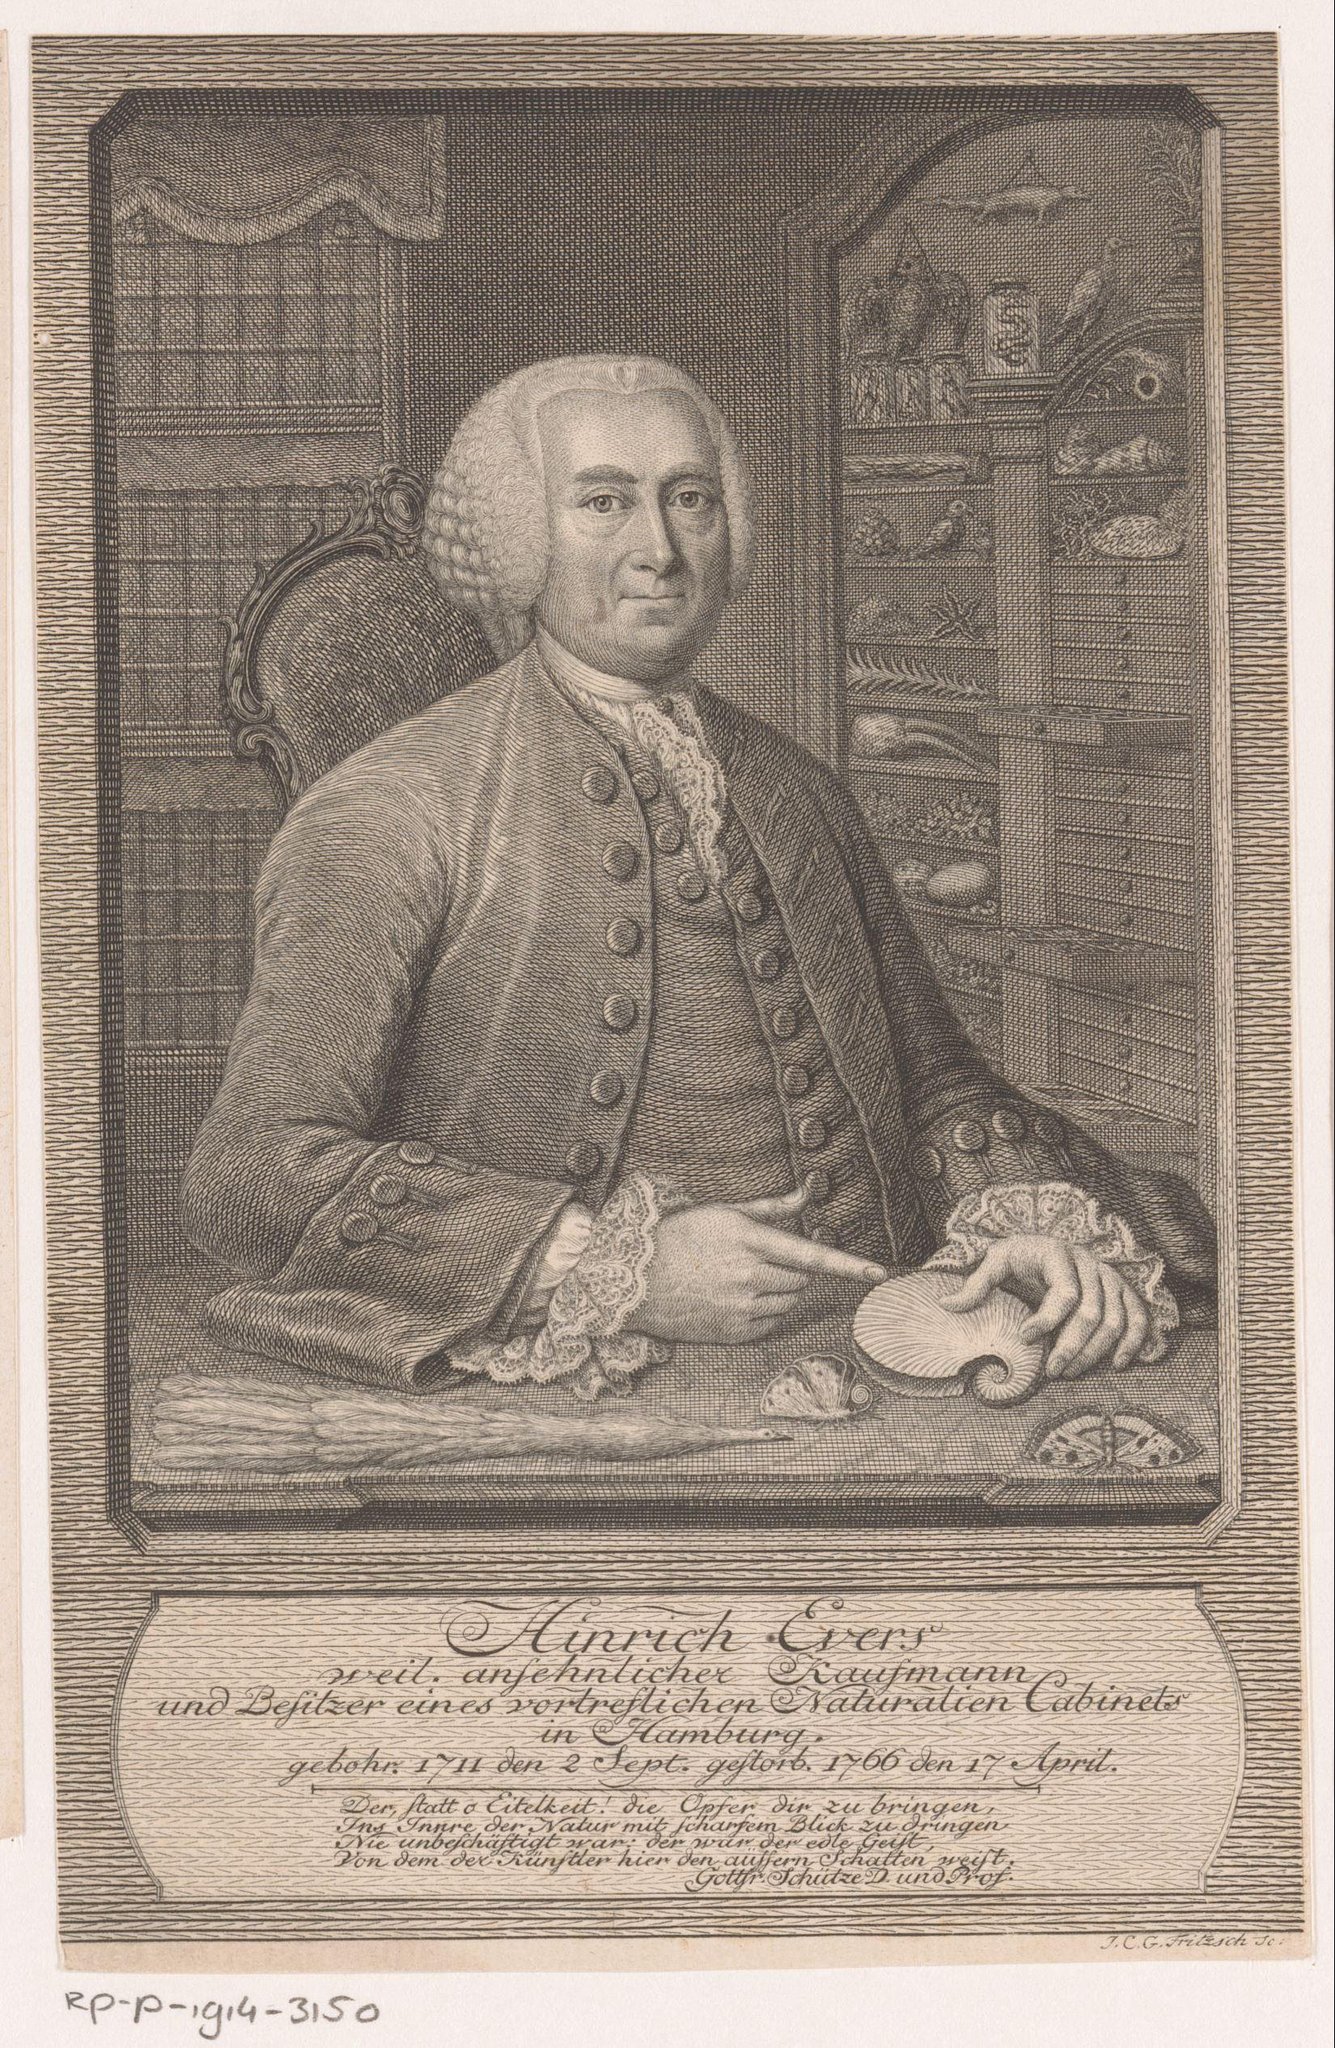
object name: print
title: Portret van Hinrich Evers in zijn naturaliënkabinet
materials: paper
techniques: engraving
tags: bookshelves, historical persons, cabinet of curiosities, 'kunst- und wunderkammer'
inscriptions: collector's mark: Lugt 2228